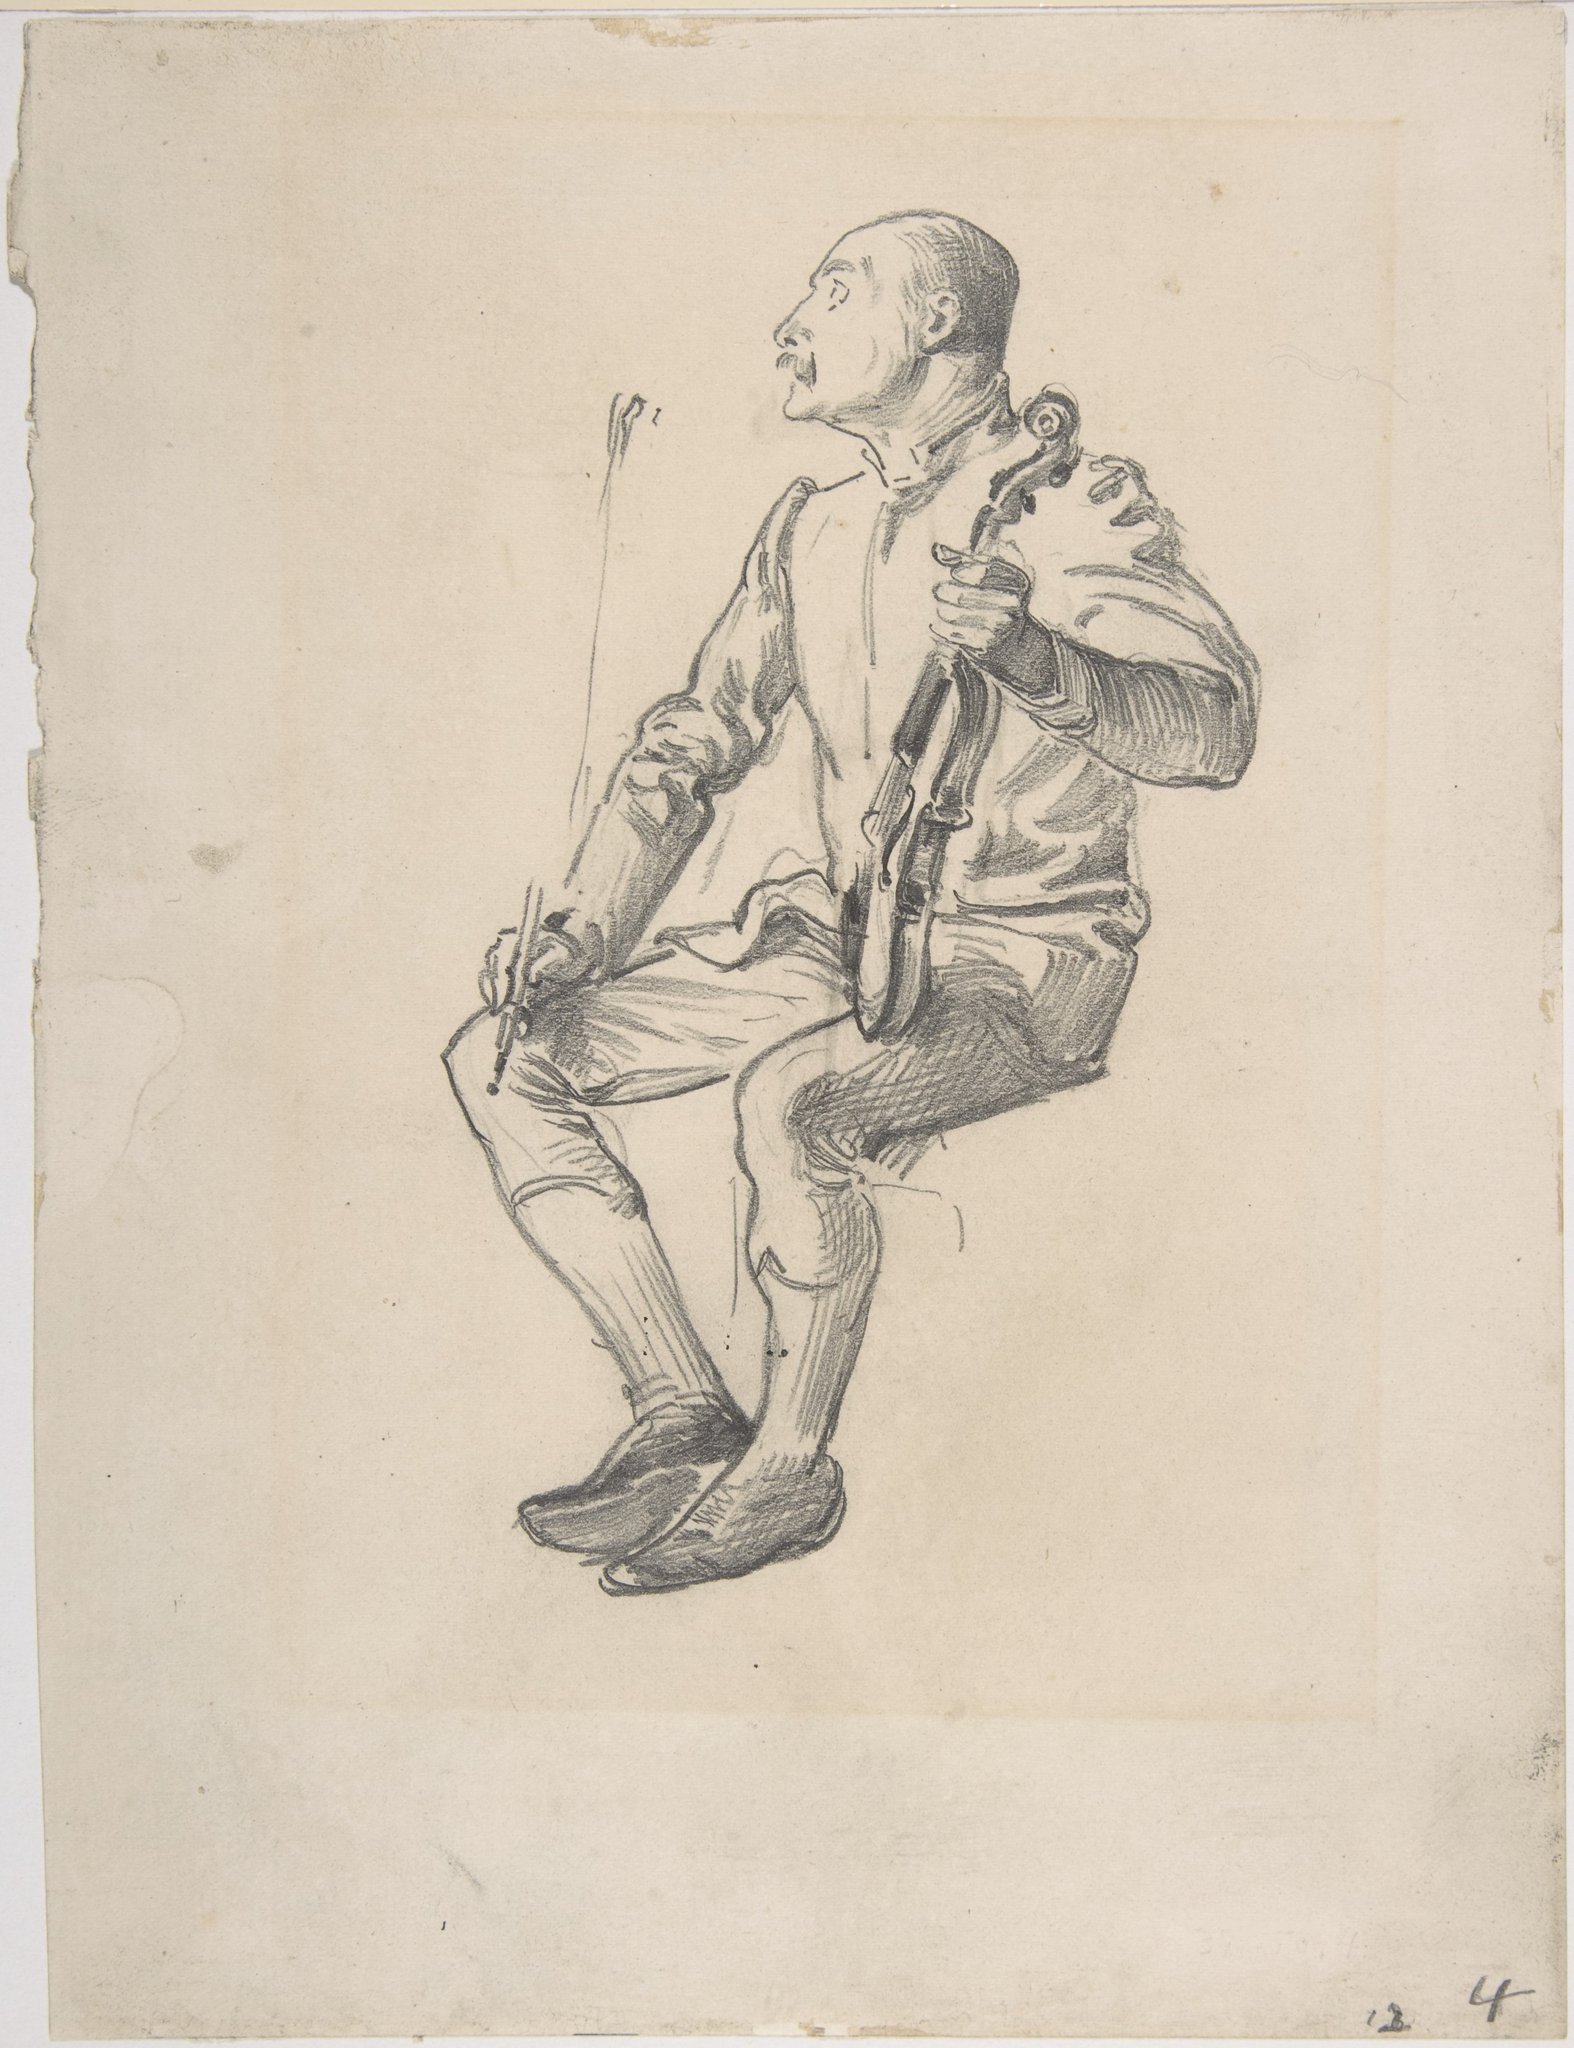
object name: drawing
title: Violinist: study from life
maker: george du maurier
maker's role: artist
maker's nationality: british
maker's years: 1834-1896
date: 1851-1900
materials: graphite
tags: men,violins